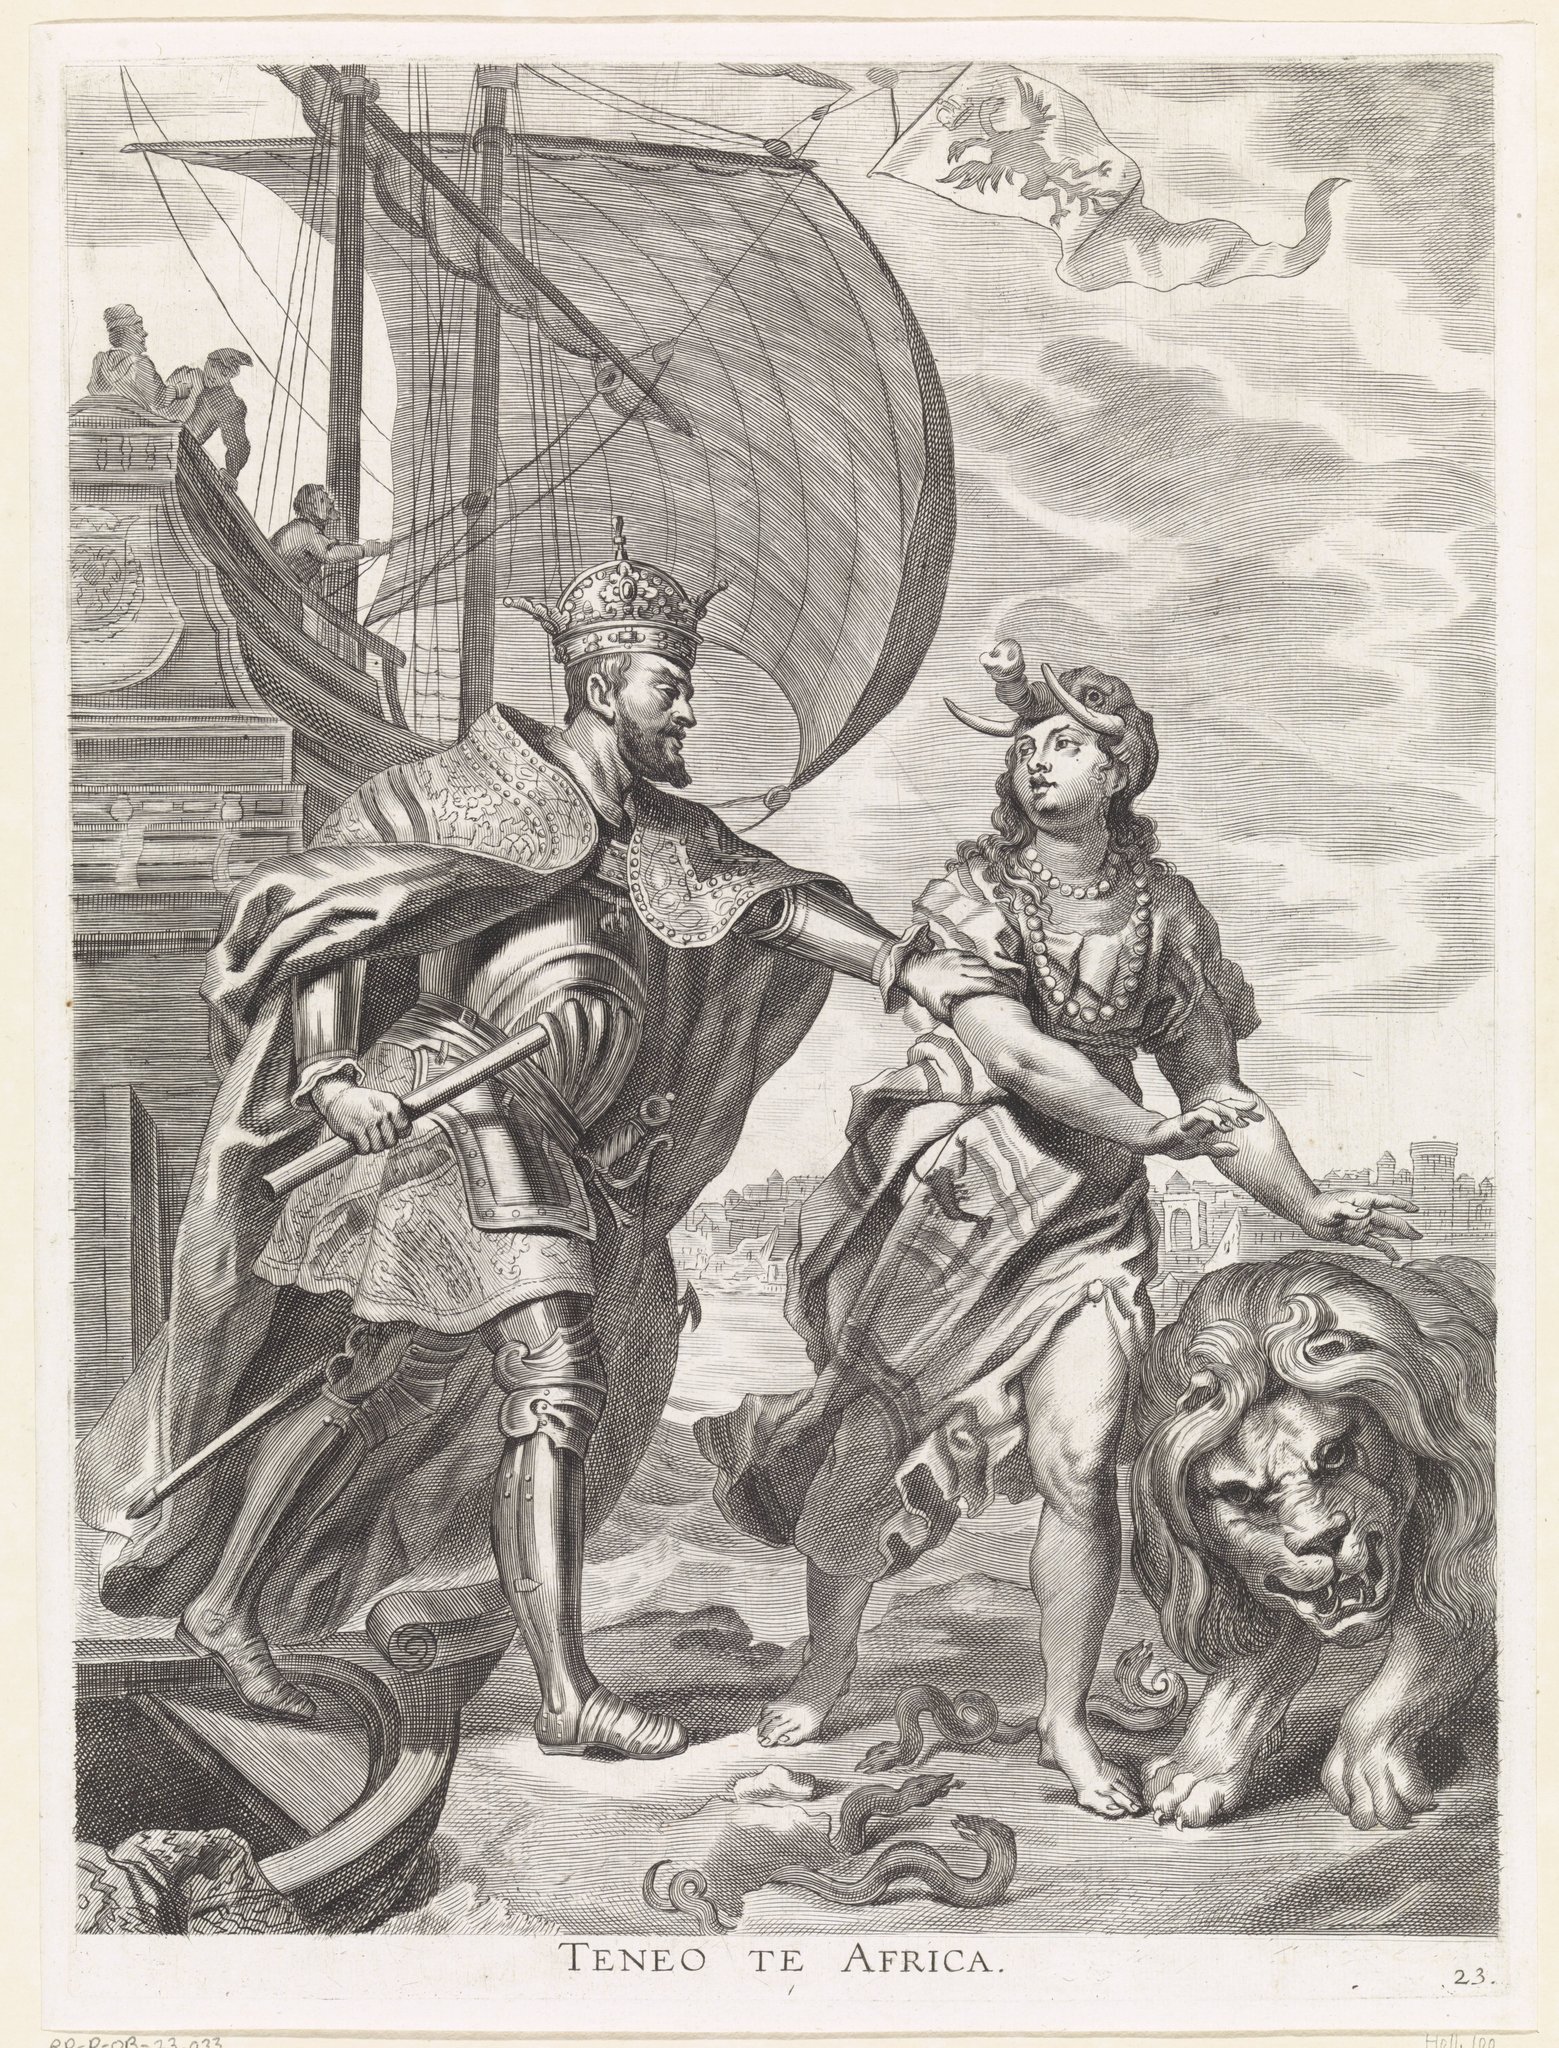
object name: print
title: Intocht van Ferdinand van Oostenrijk in Gent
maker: jacob neefs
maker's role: print maker, publisher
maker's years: 1610-1660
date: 1636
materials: paper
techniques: engraving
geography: antwerp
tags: charles v (holy roman emperor and king of spain), flag raising, sailing-ship, sailing-boat, africa represented allegorically; 'africa' (ripa), prince, beasts of prey, predatory animals: lion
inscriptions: collector's mark: Lugt 240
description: Karel V stapt van boord en zet voet aan land in Afrika. De keizer grijpt de personificatie van het continent Afrika, die vergezeld is door een leeuw, bij de arm. Links een schip waar door een man een vaandel wordt gehesen met daarop een gekroonde adelaar. Verbeelding van de strijd tegen de Turken en de verovering van Tunis in Noord-Afrika, 1535. Voorstelling rechts op de voorzijde van de triomfpoort Arcus Caroli op de Vrijdagmarkt. Prent maakt deel uit van een serie, die de uitgave van de beschrijving van de intocht van de Kardinaal Infant Ferdinand van Oostenrijk te Gent op 28 januari 1635 als de nieuwe landvoogd voor de Spaanse Nederlanden illustreert.